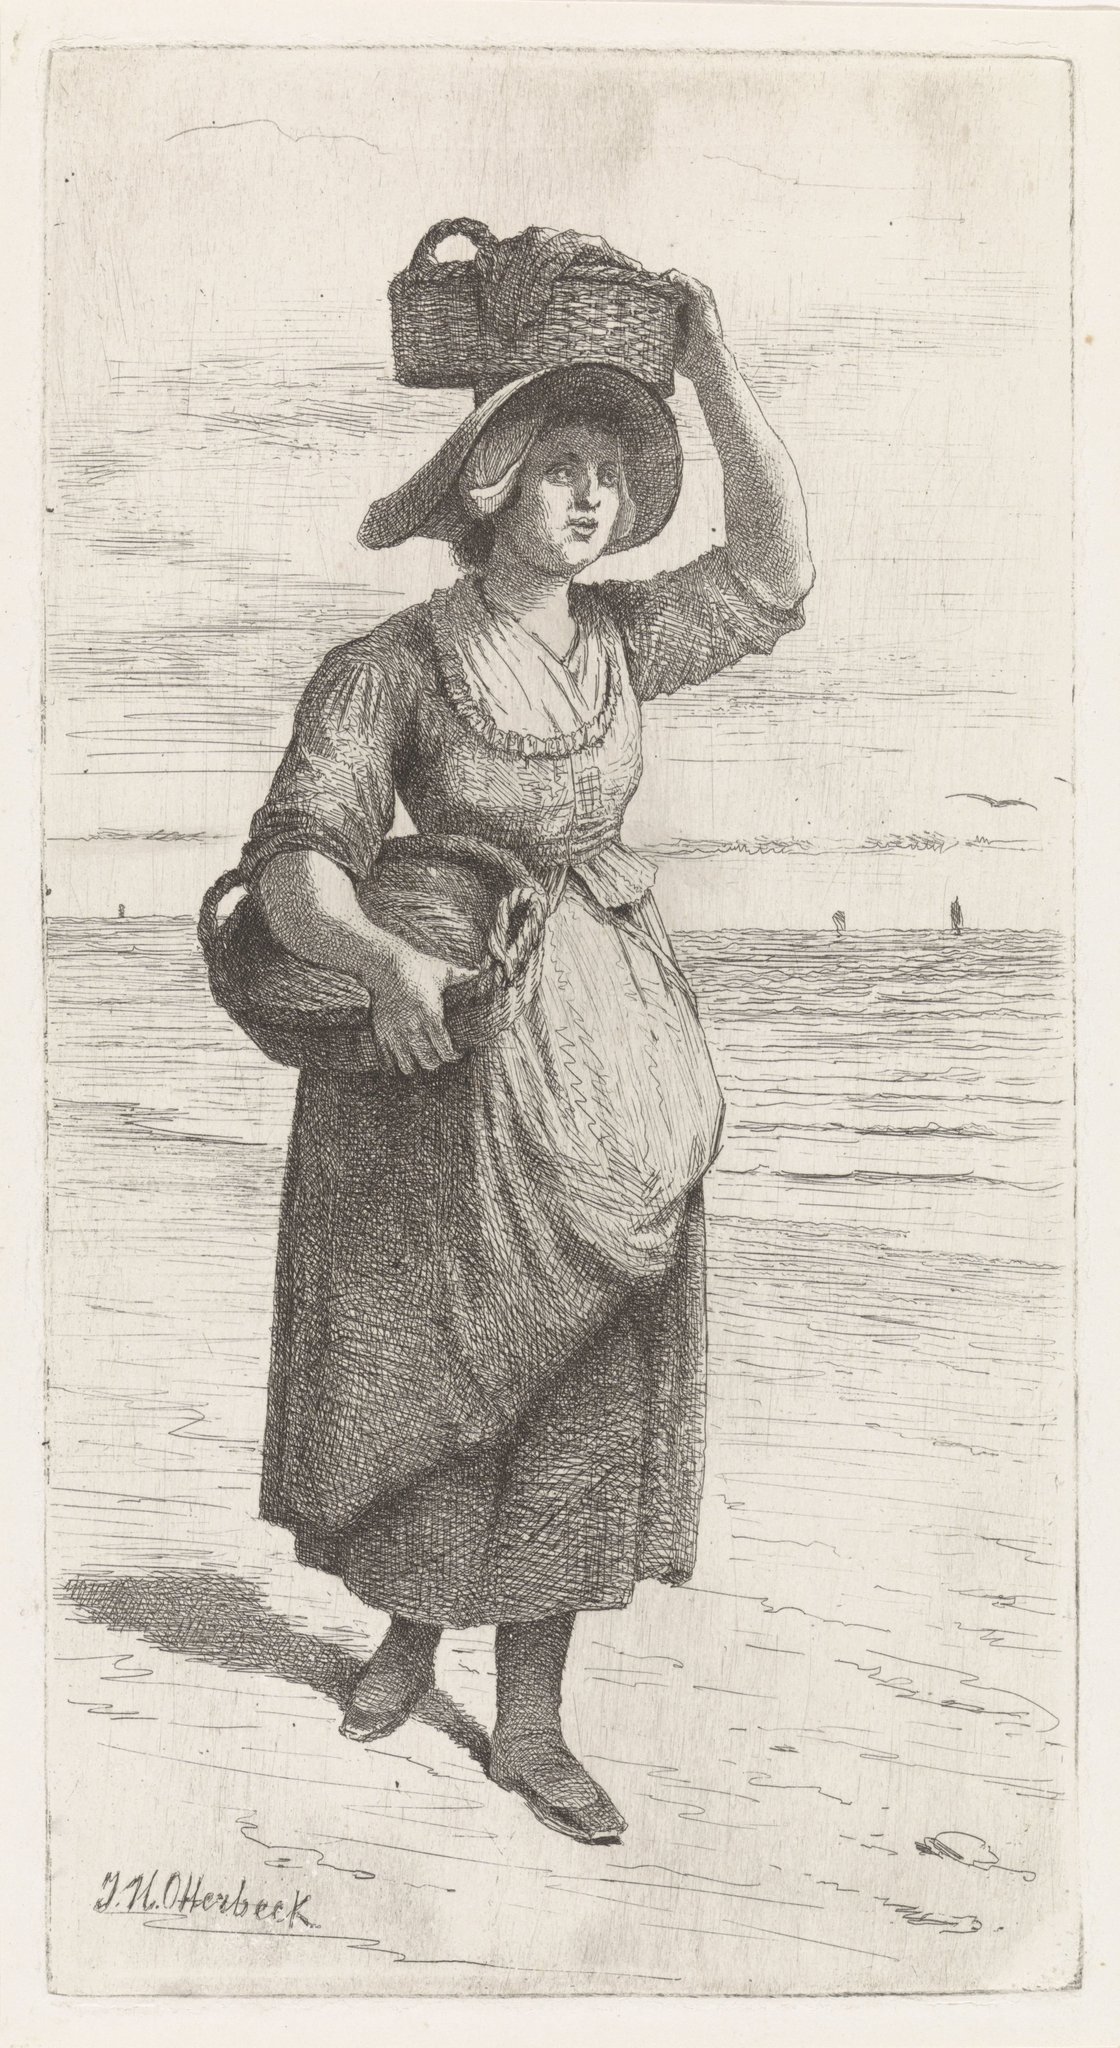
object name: print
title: Vrouw met manden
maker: jacobus hermanus otterbeek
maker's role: painter, print maker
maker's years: 1839-1902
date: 1854-1902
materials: paper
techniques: etching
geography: the hague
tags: carrying something in basket, bag, rucksack, etc.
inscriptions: collector's mark: Lugt 2228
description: Een vrouw loopt op het strand. Ze draagt een mand onder haar arm en eentje op haar hoofd.